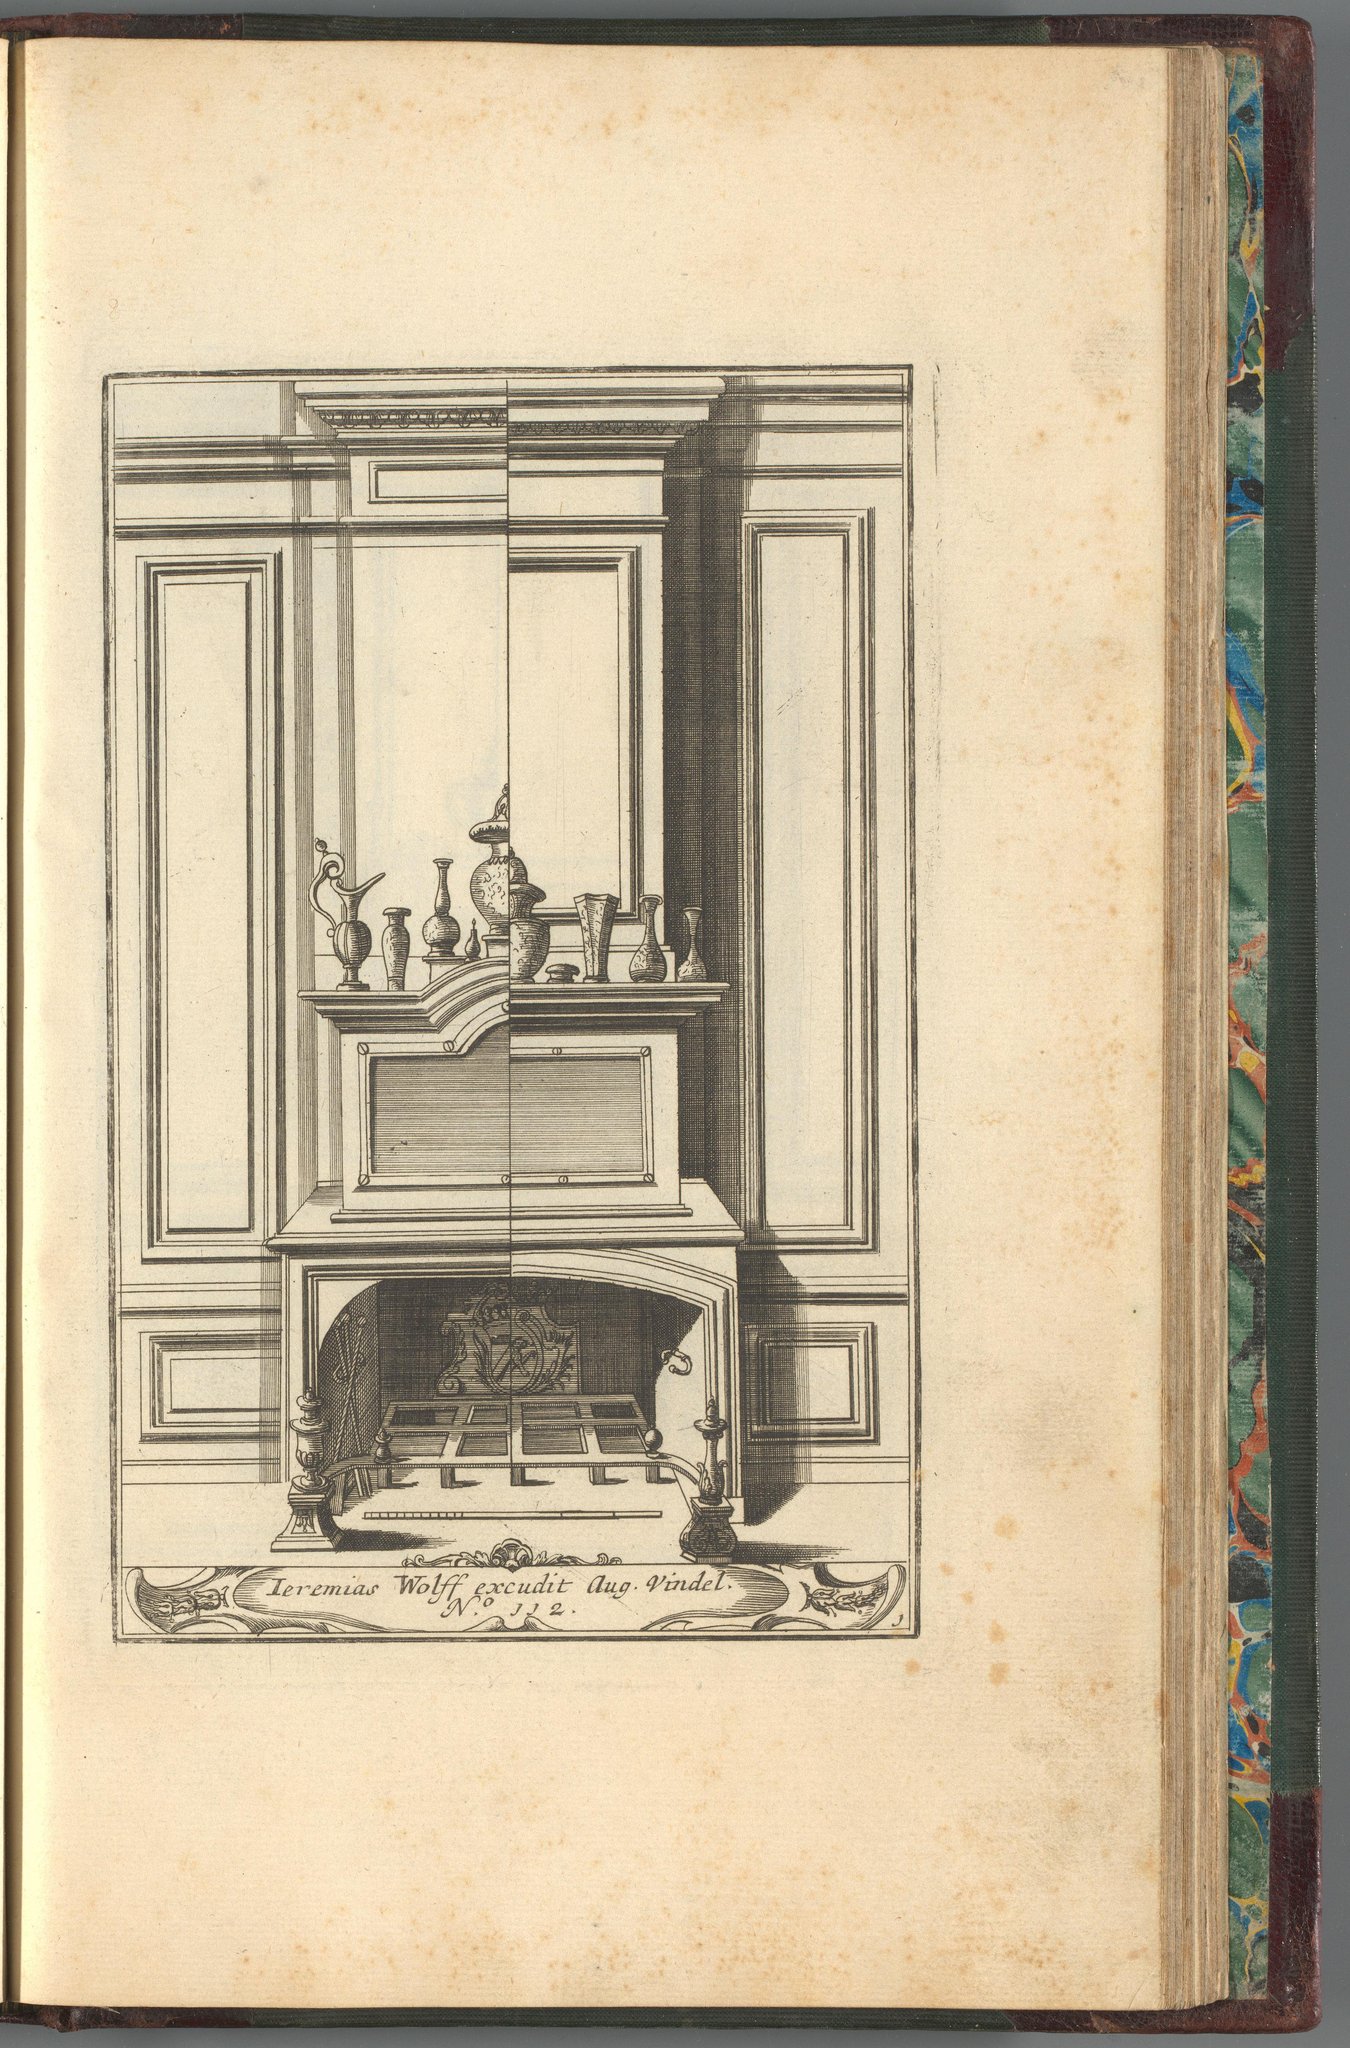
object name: print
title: Ontwerp van schoorsteenmantel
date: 1686-1724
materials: paper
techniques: etching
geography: augsburg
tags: ornaments ~ art, chimney-piece, mantelpiece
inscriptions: number: ‘No. 112.’, number: ‘1’, signature: ‘Ieremias Wolff excudit Aug. Vindel.’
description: Ontwerp van een schoorsteenmantel met twee varianten. Beide met kannen en vazen. Prent maakt deel uit van een album. Hoogstwaarschijnlijk kopie naar Frans origineel.